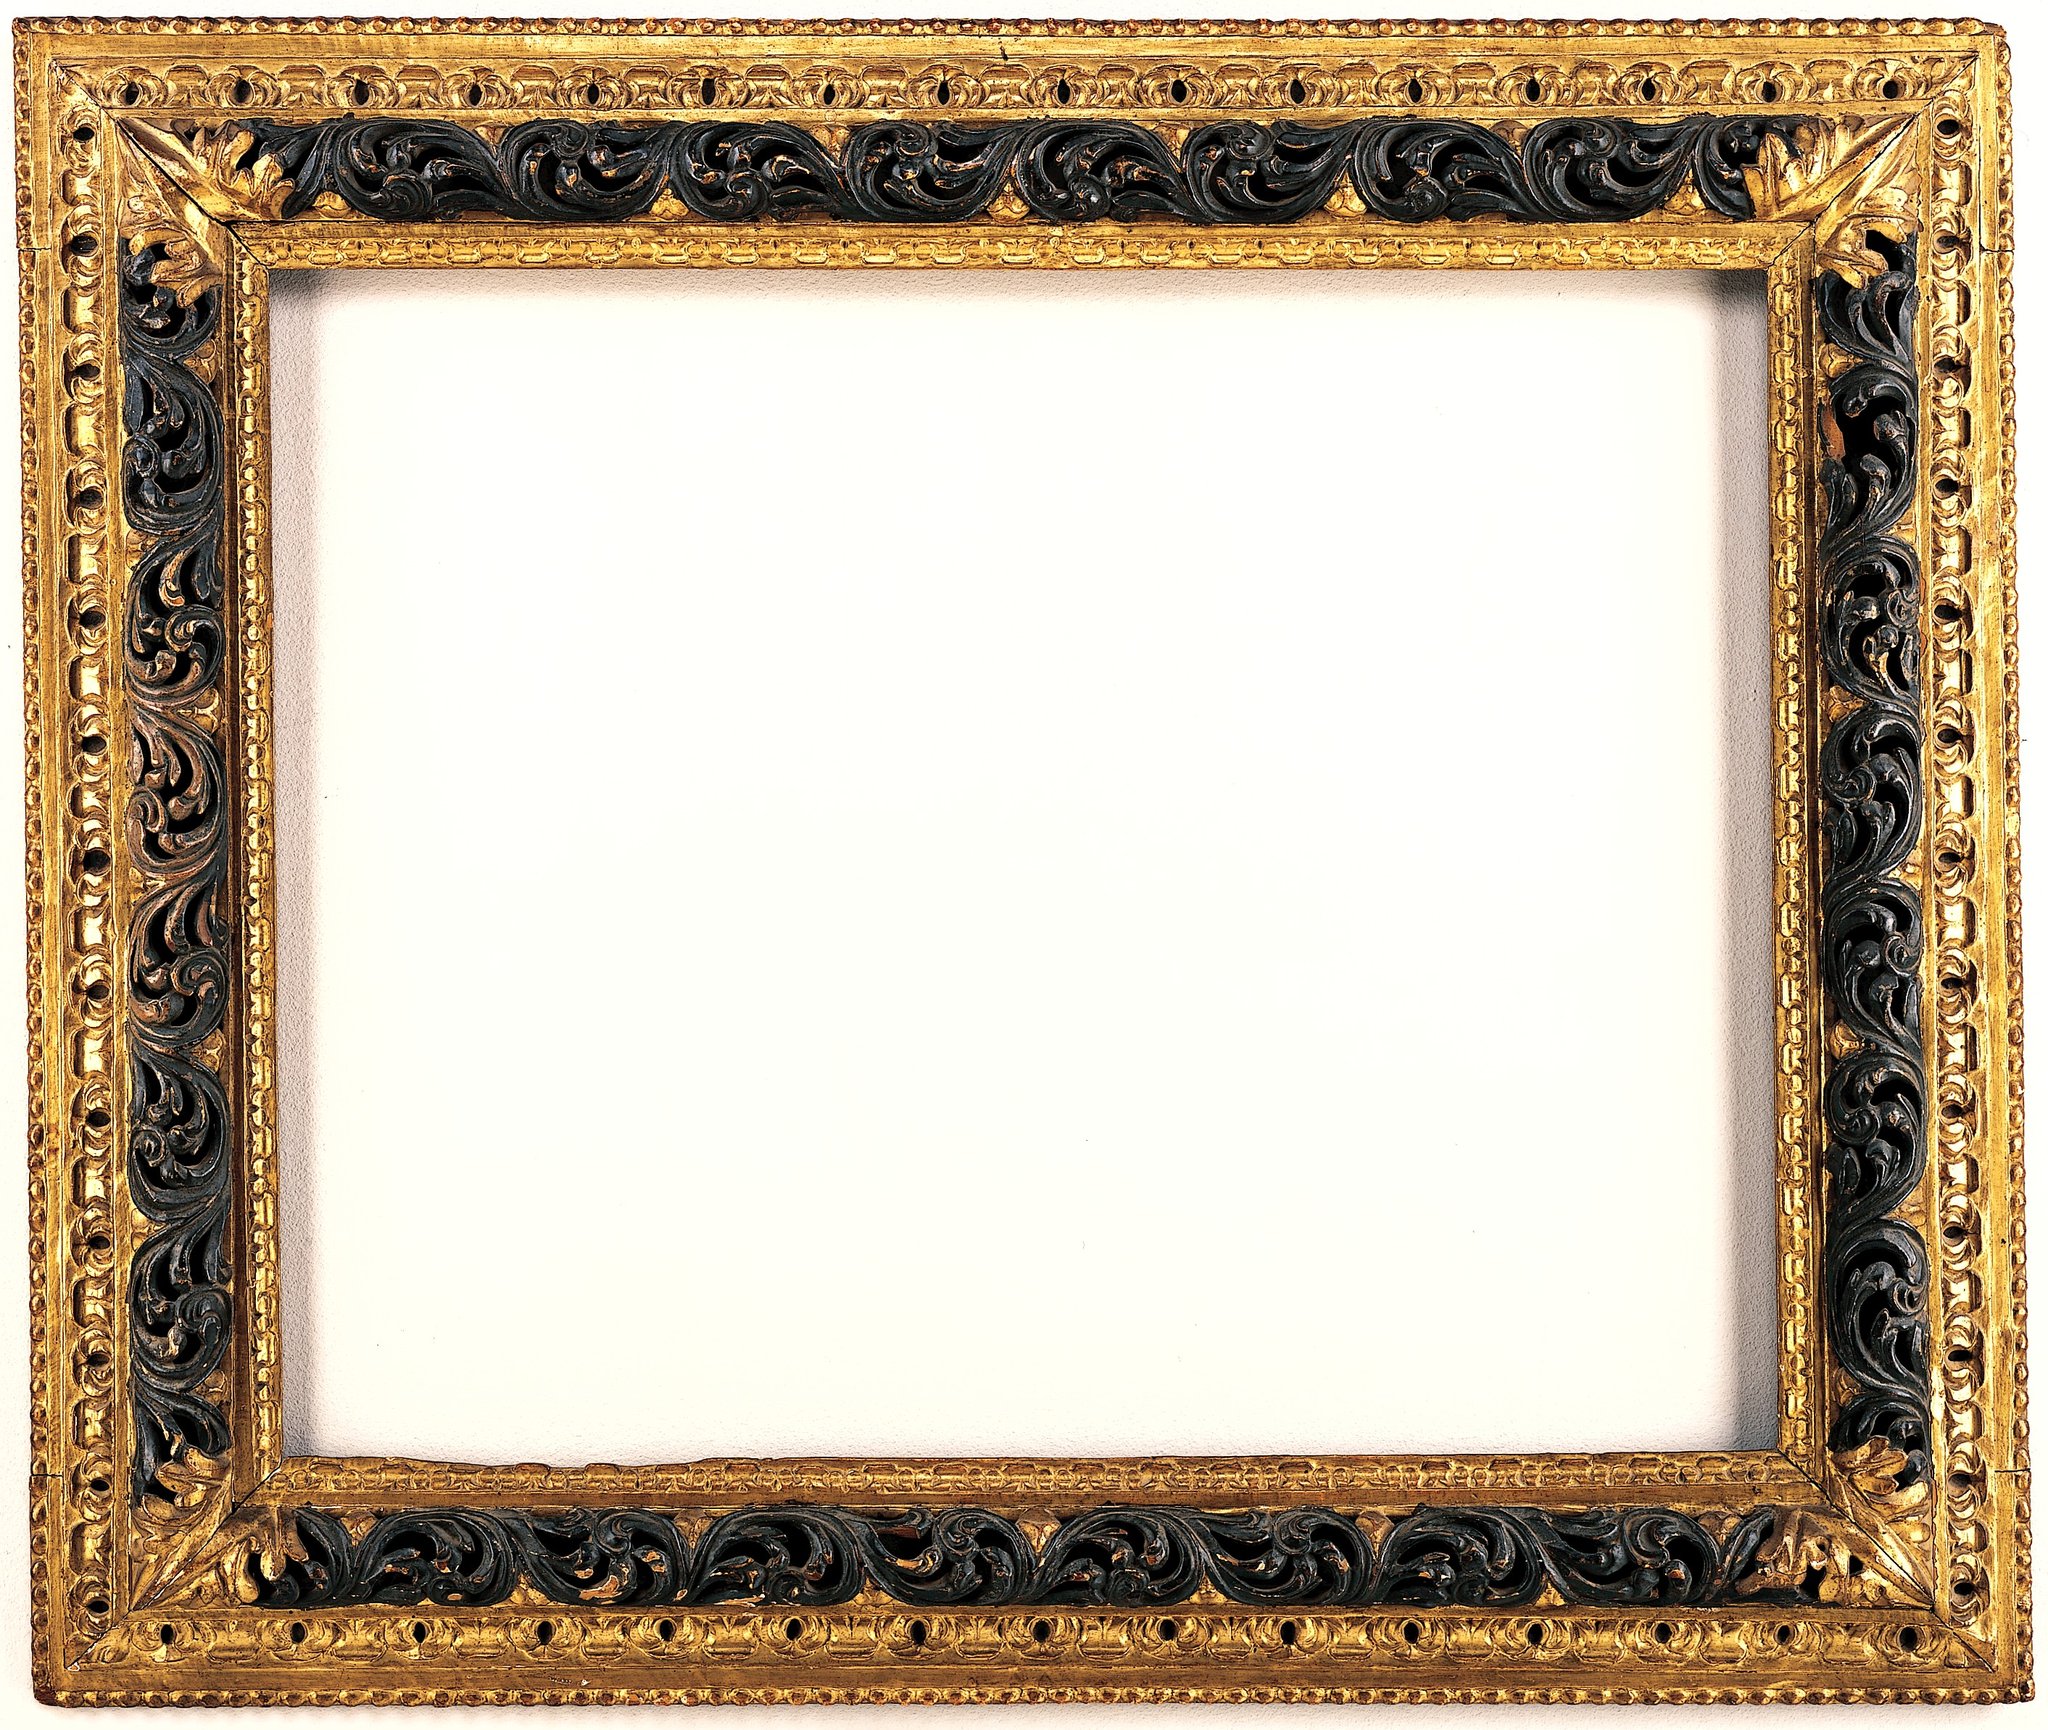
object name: frame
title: Wreath frame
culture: italian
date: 1567-1600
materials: wood